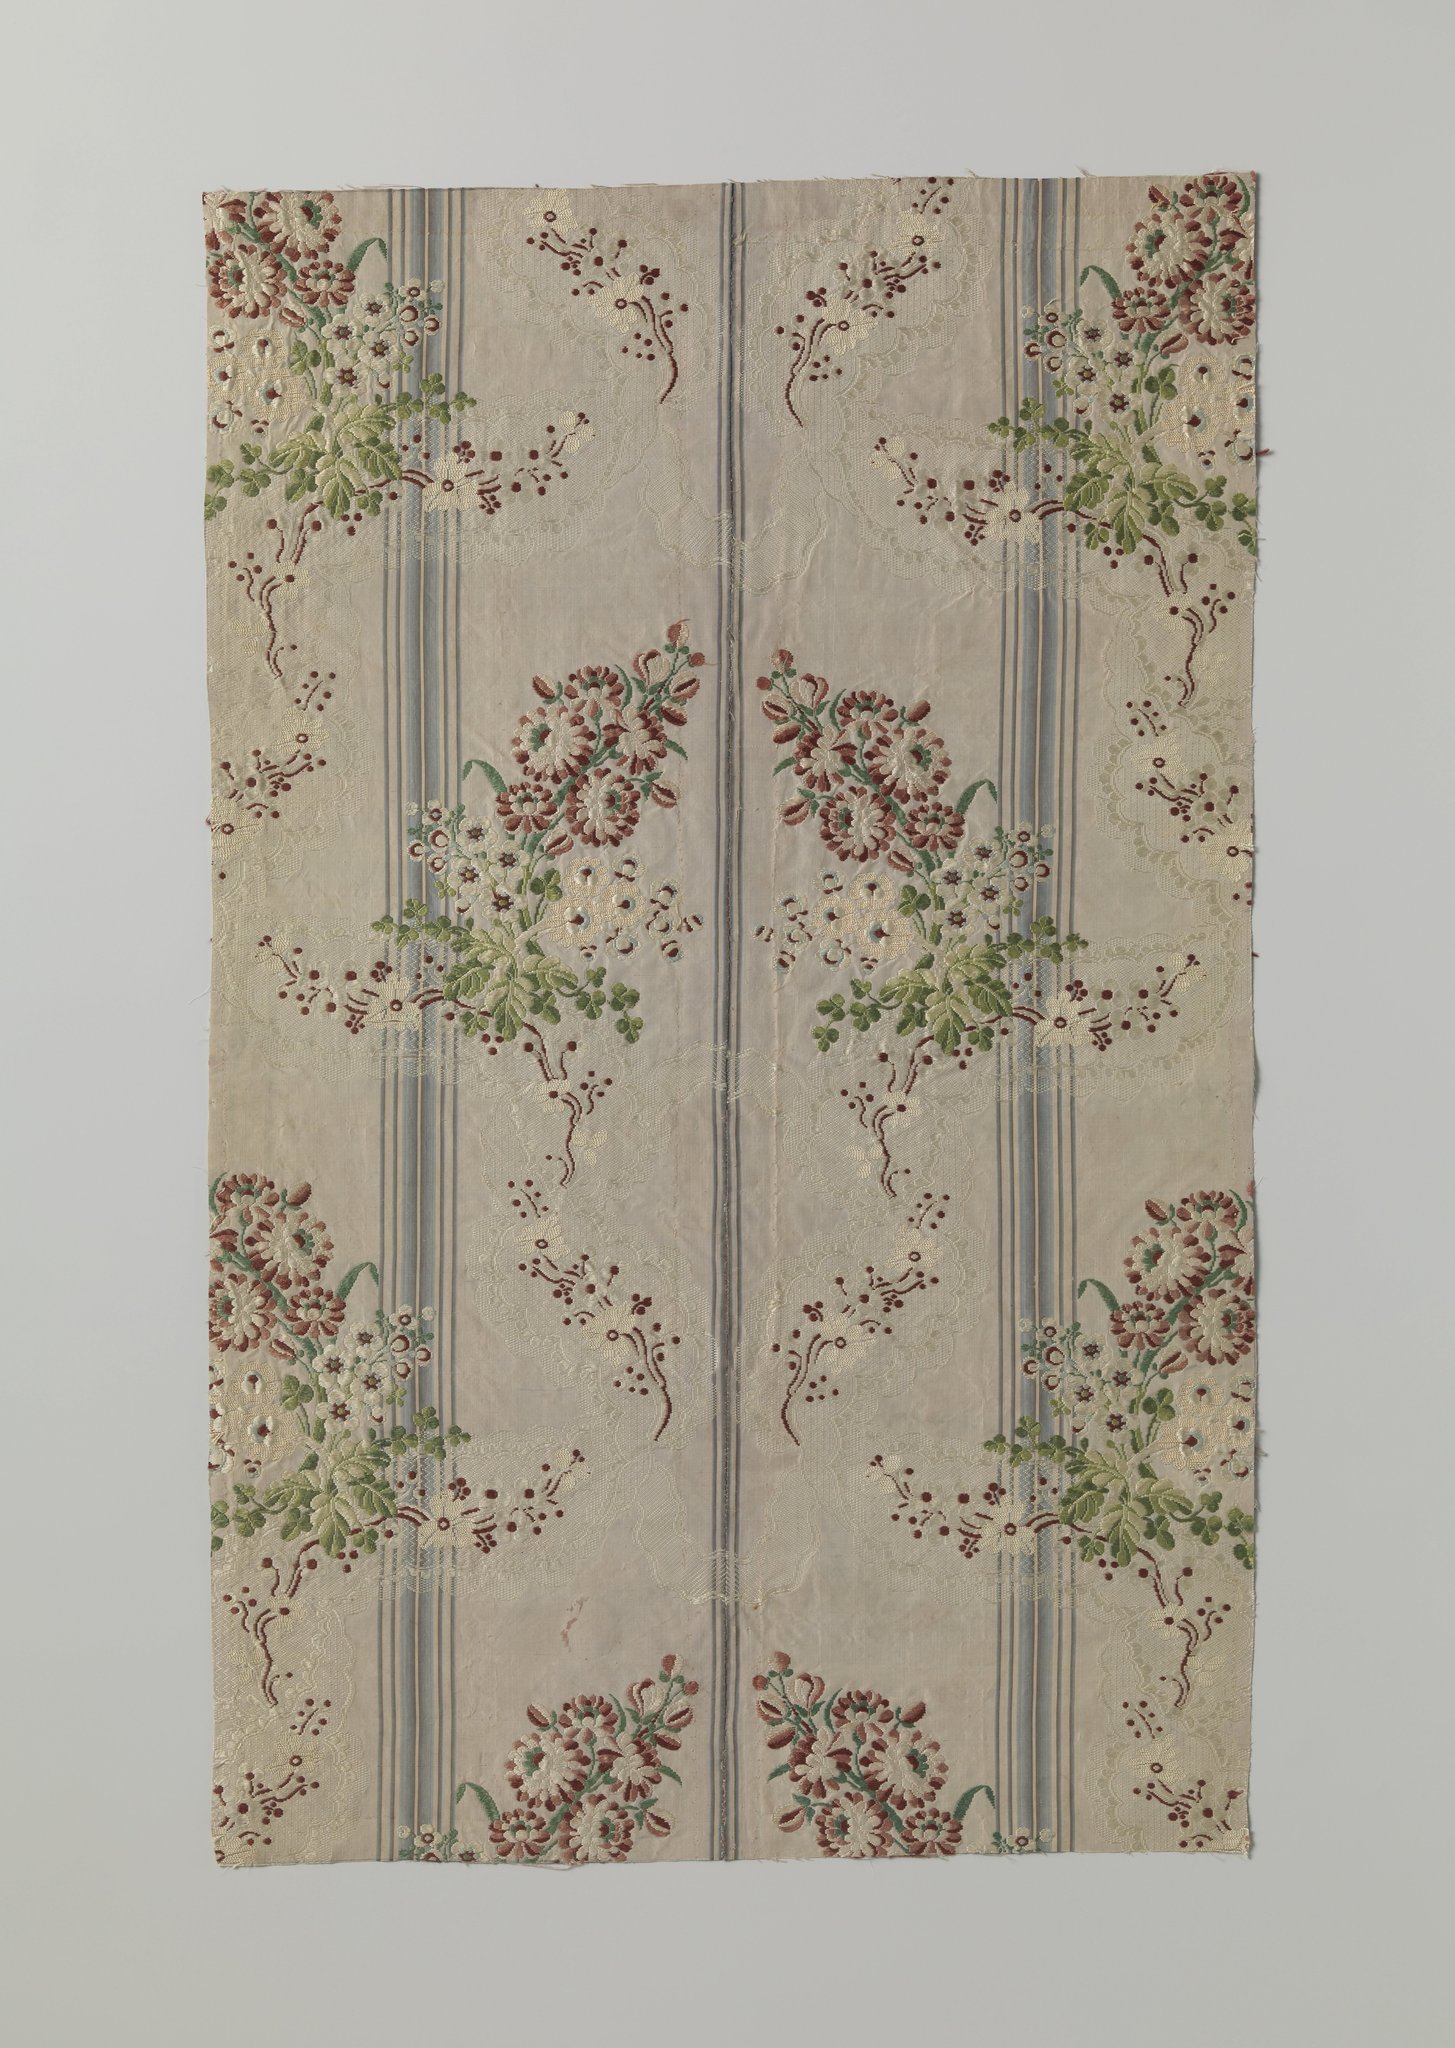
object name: fragment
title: Fragment veelkleurig zijdeweefsel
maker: Anonymous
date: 1740-1760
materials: silk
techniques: brocade, weave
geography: france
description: Fragment veelkleurig zijdeweefsel met een grijze grond waarop blauwe strepen. Over de strepen loopt een witte kantslinger waarin een rood met wit gekleurde bloemenrank en waartussen bloemtakken in rood, groen en wit.